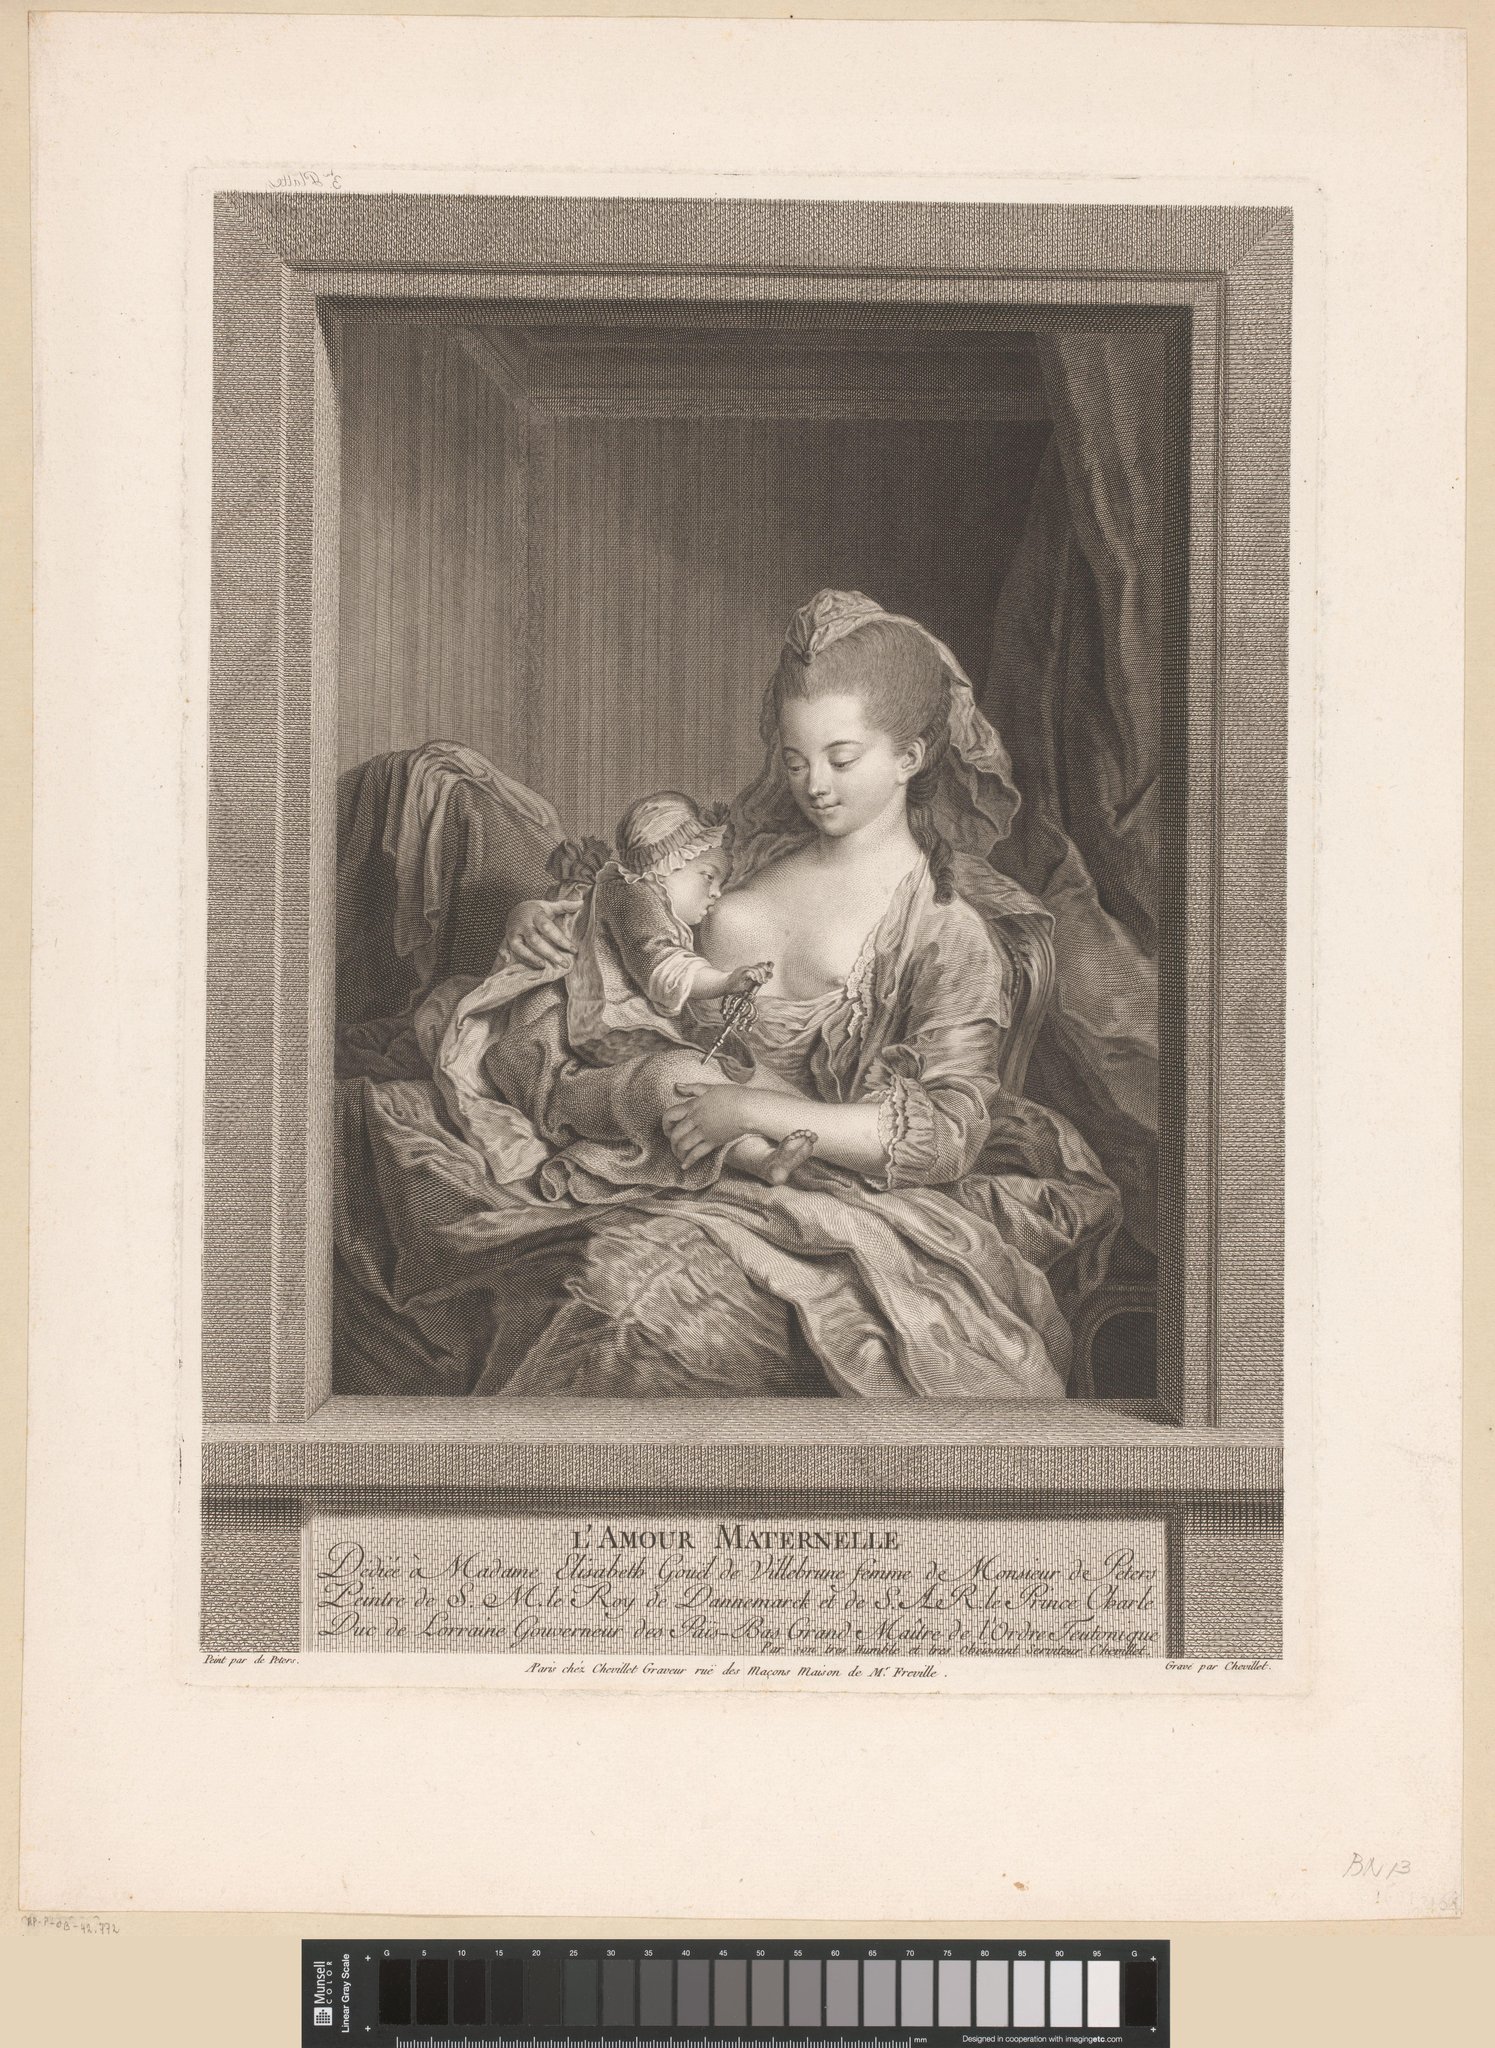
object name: print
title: L'Amour Maternelle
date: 1772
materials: paper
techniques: engraving, etching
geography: france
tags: breasts giving milk, feeding a baby, rattle (child's toy)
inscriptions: collector's mark: Lugt 240